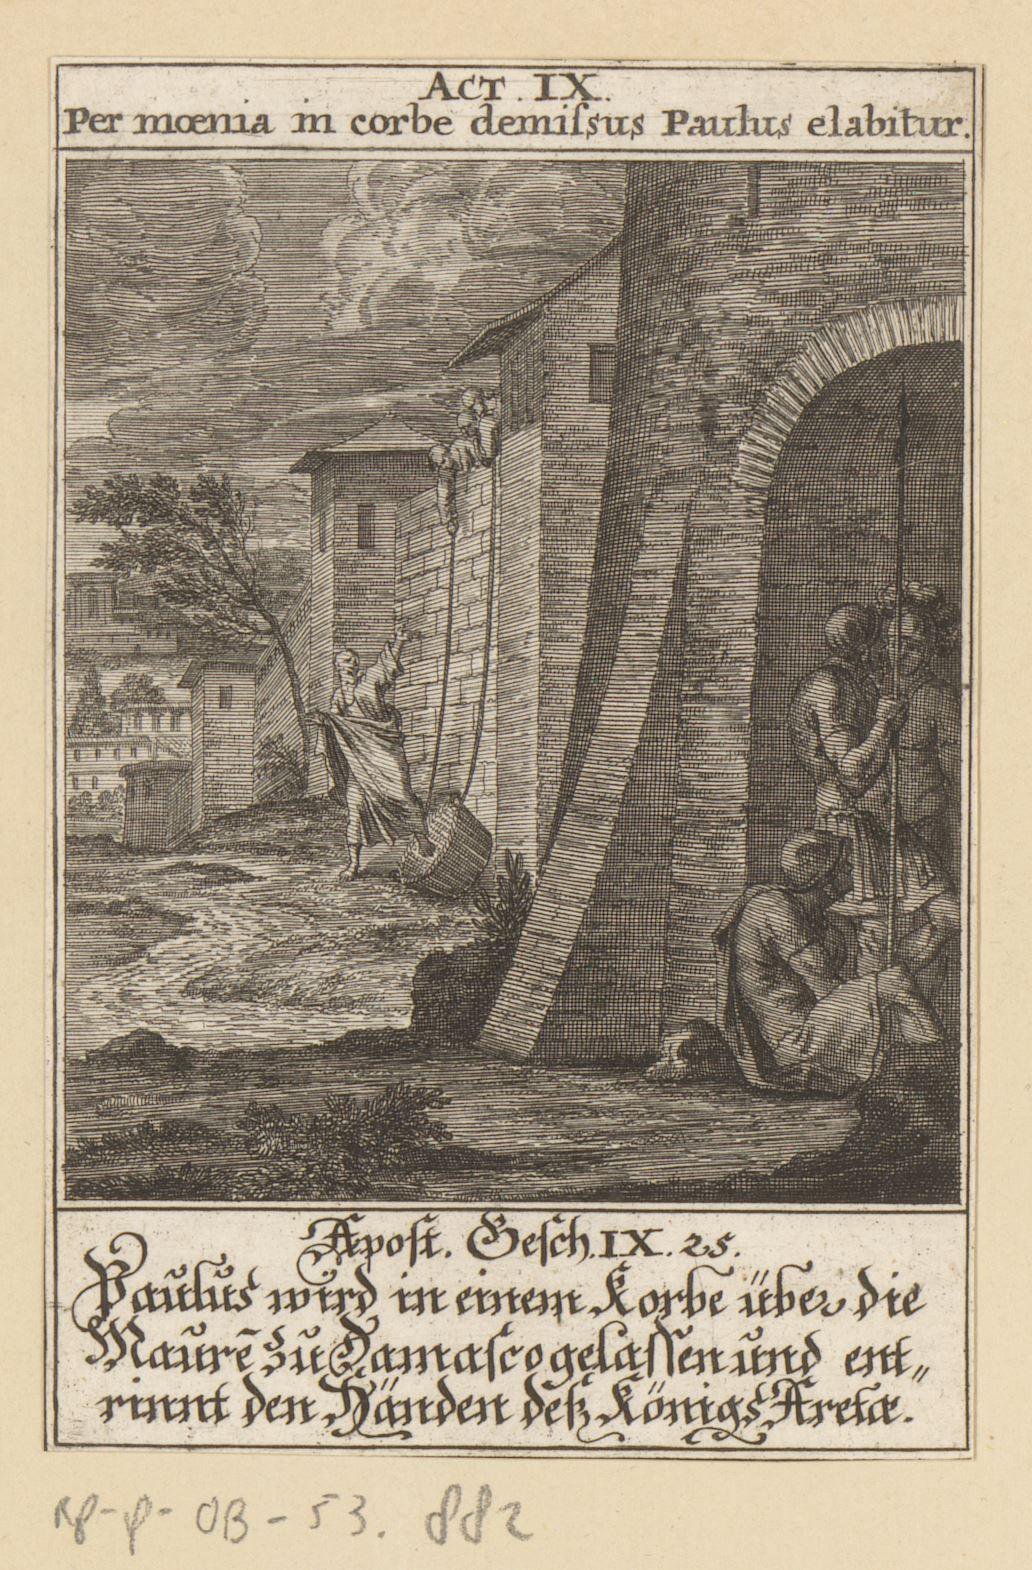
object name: print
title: Apostel Paulus in een mand over een muur gelaten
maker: Anonymous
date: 1697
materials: paper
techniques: etching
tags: disciples let paul down the wall of the city in a basket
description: Prent ook gebruikt in: Biblia ectypa : Bildnussen auss Heiliger Schrifft. Regensburg: Chr. Wiegel, 1697.